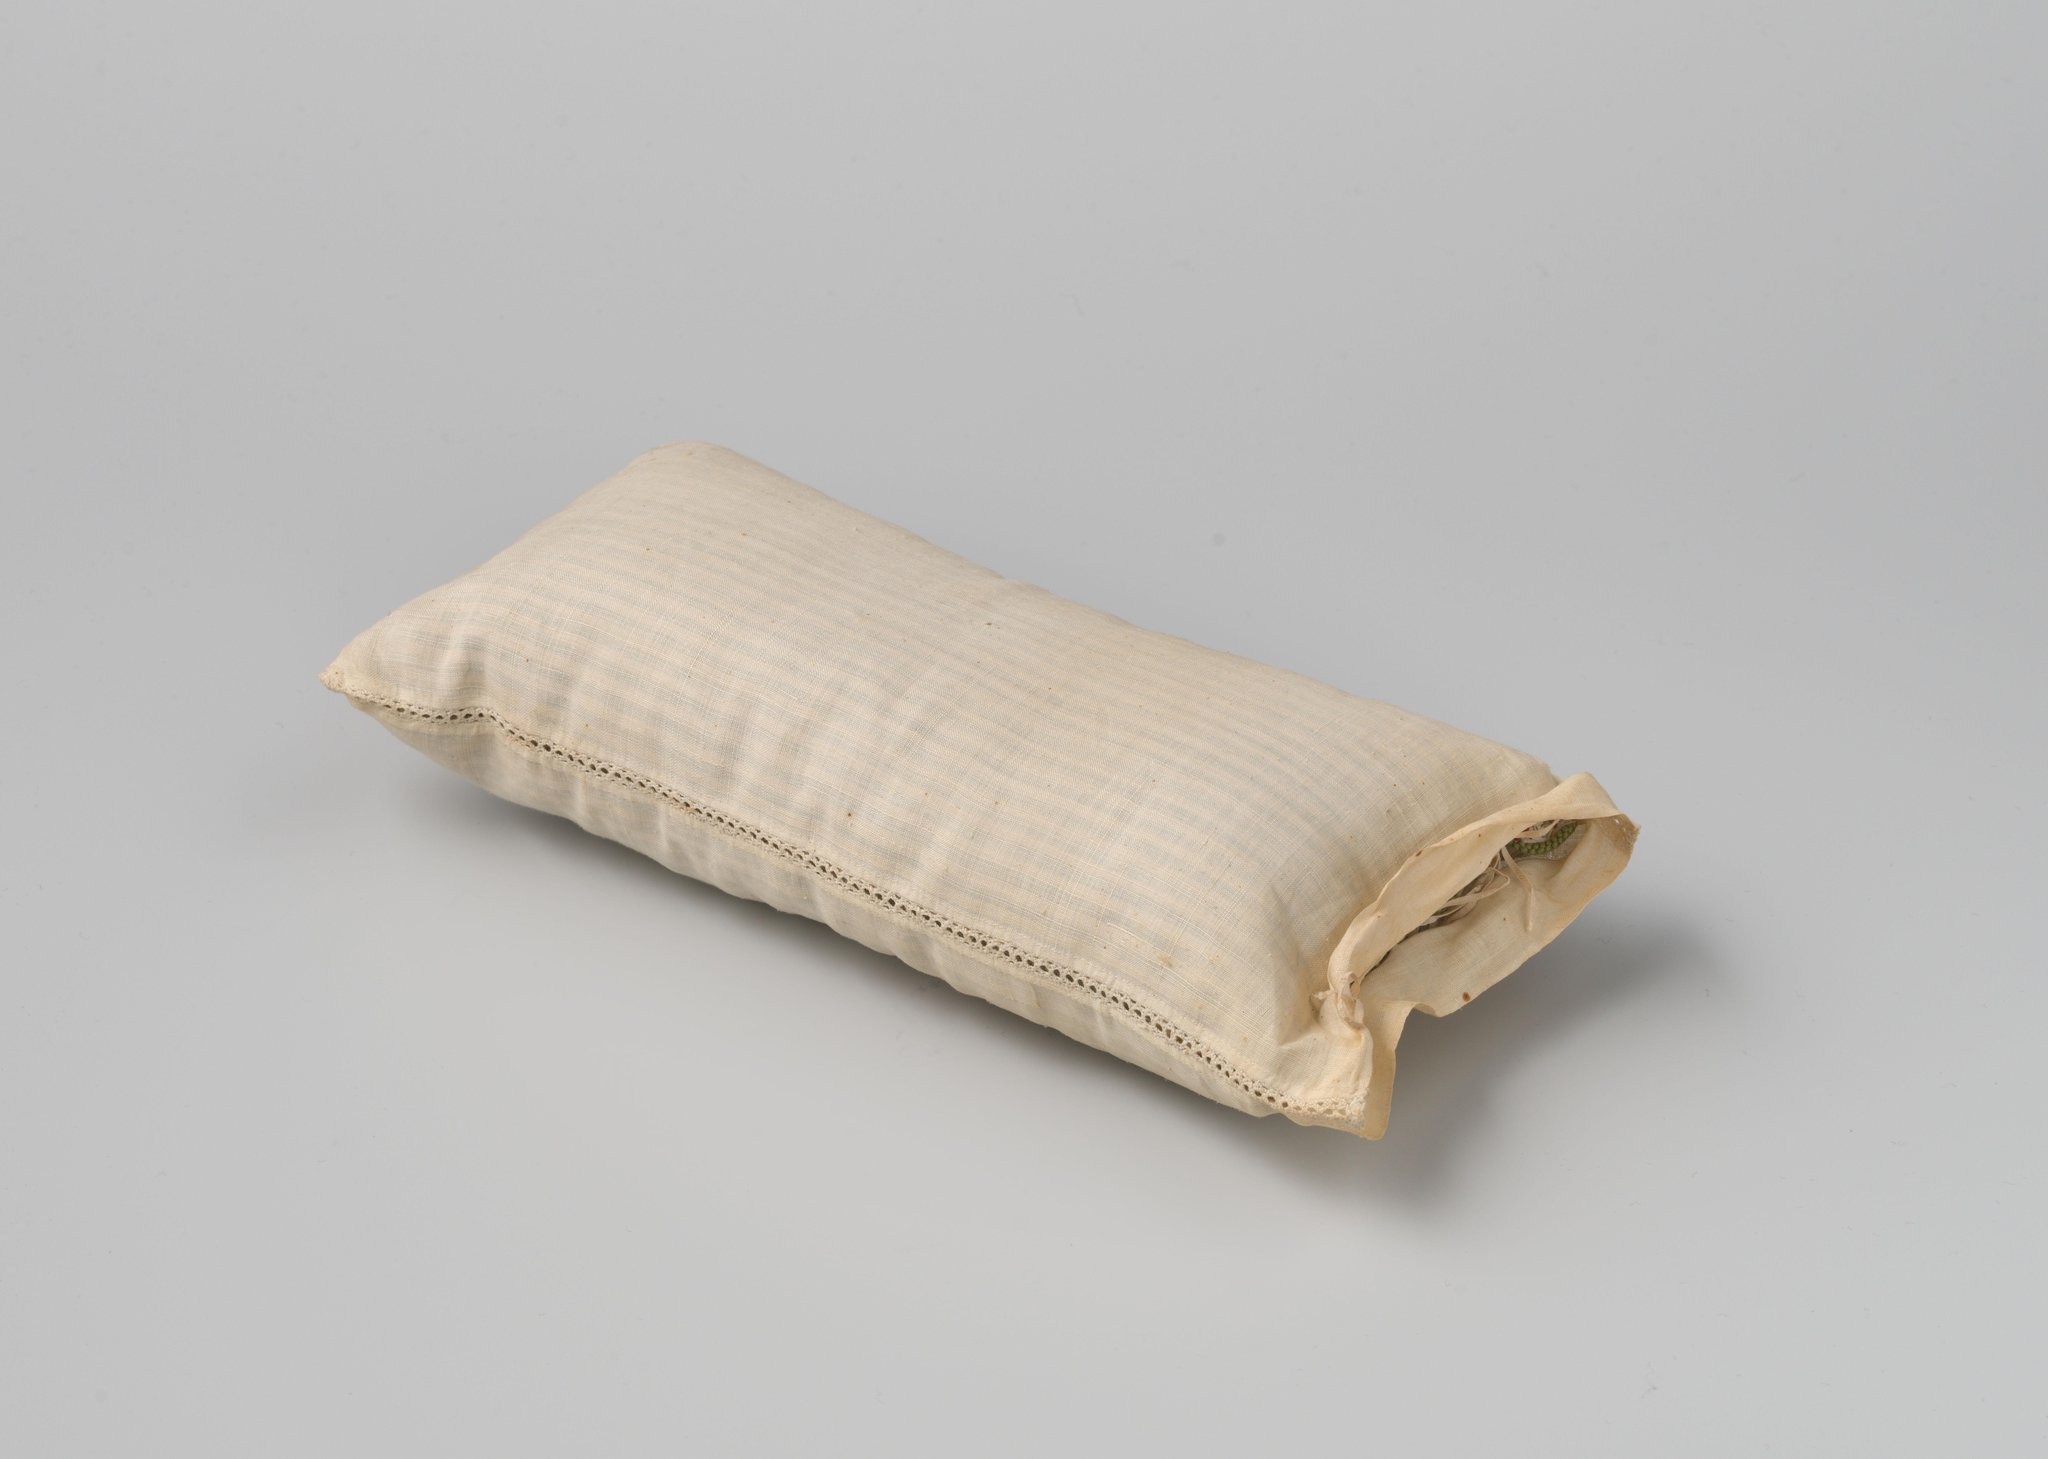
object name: tick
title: Overtrek voor een matras van wit linnen, aan drie zijden met tussenzetzel van kloskant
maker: Anonymous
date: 1690-1710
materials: linen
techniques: lace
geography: amsterdam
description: Overtrek voor een matras van fijn wit linnen, aan drie zijden met tussenzetsel van kloskant. De sluiting bestaat uit drie keer twee sluitbanden die aan de binnenzijde van de overtrek zijn vastgezet.